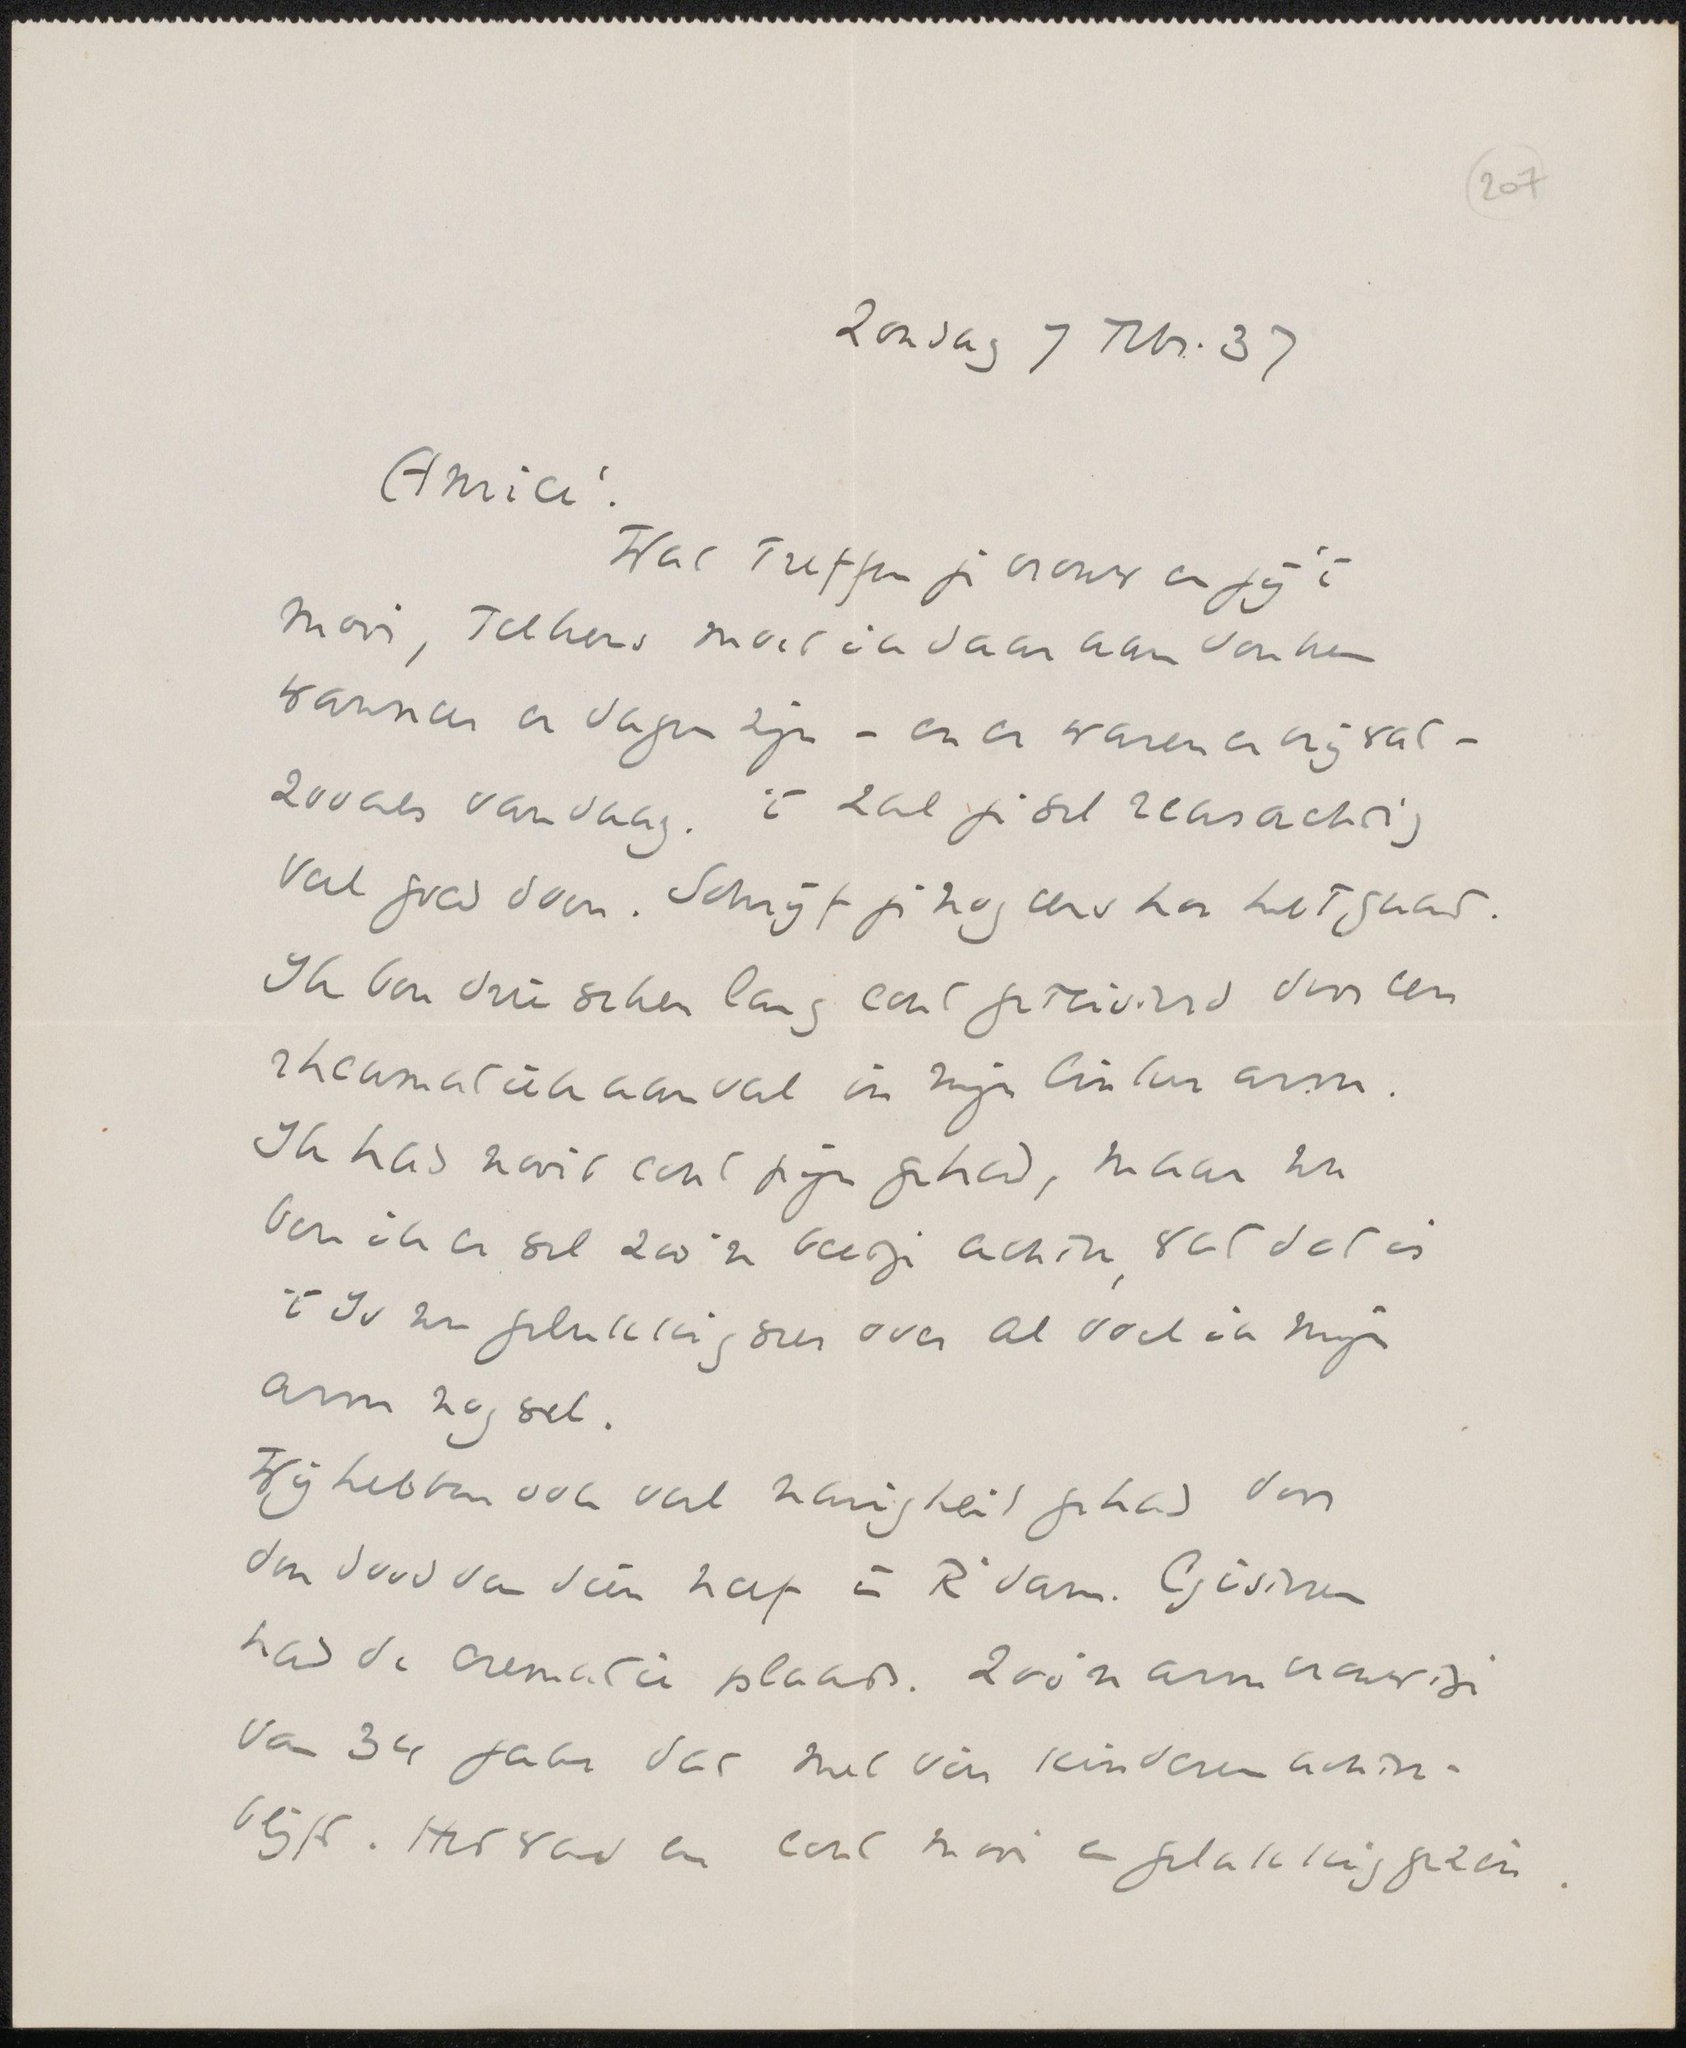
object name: letter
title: Brief aan Willem Bogtman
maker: richard nicolaüs roland holst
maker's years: 1868-1938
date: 1937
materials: ink, paper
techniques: pen, writing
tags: haarlem, willem bogtman, family life, diseases